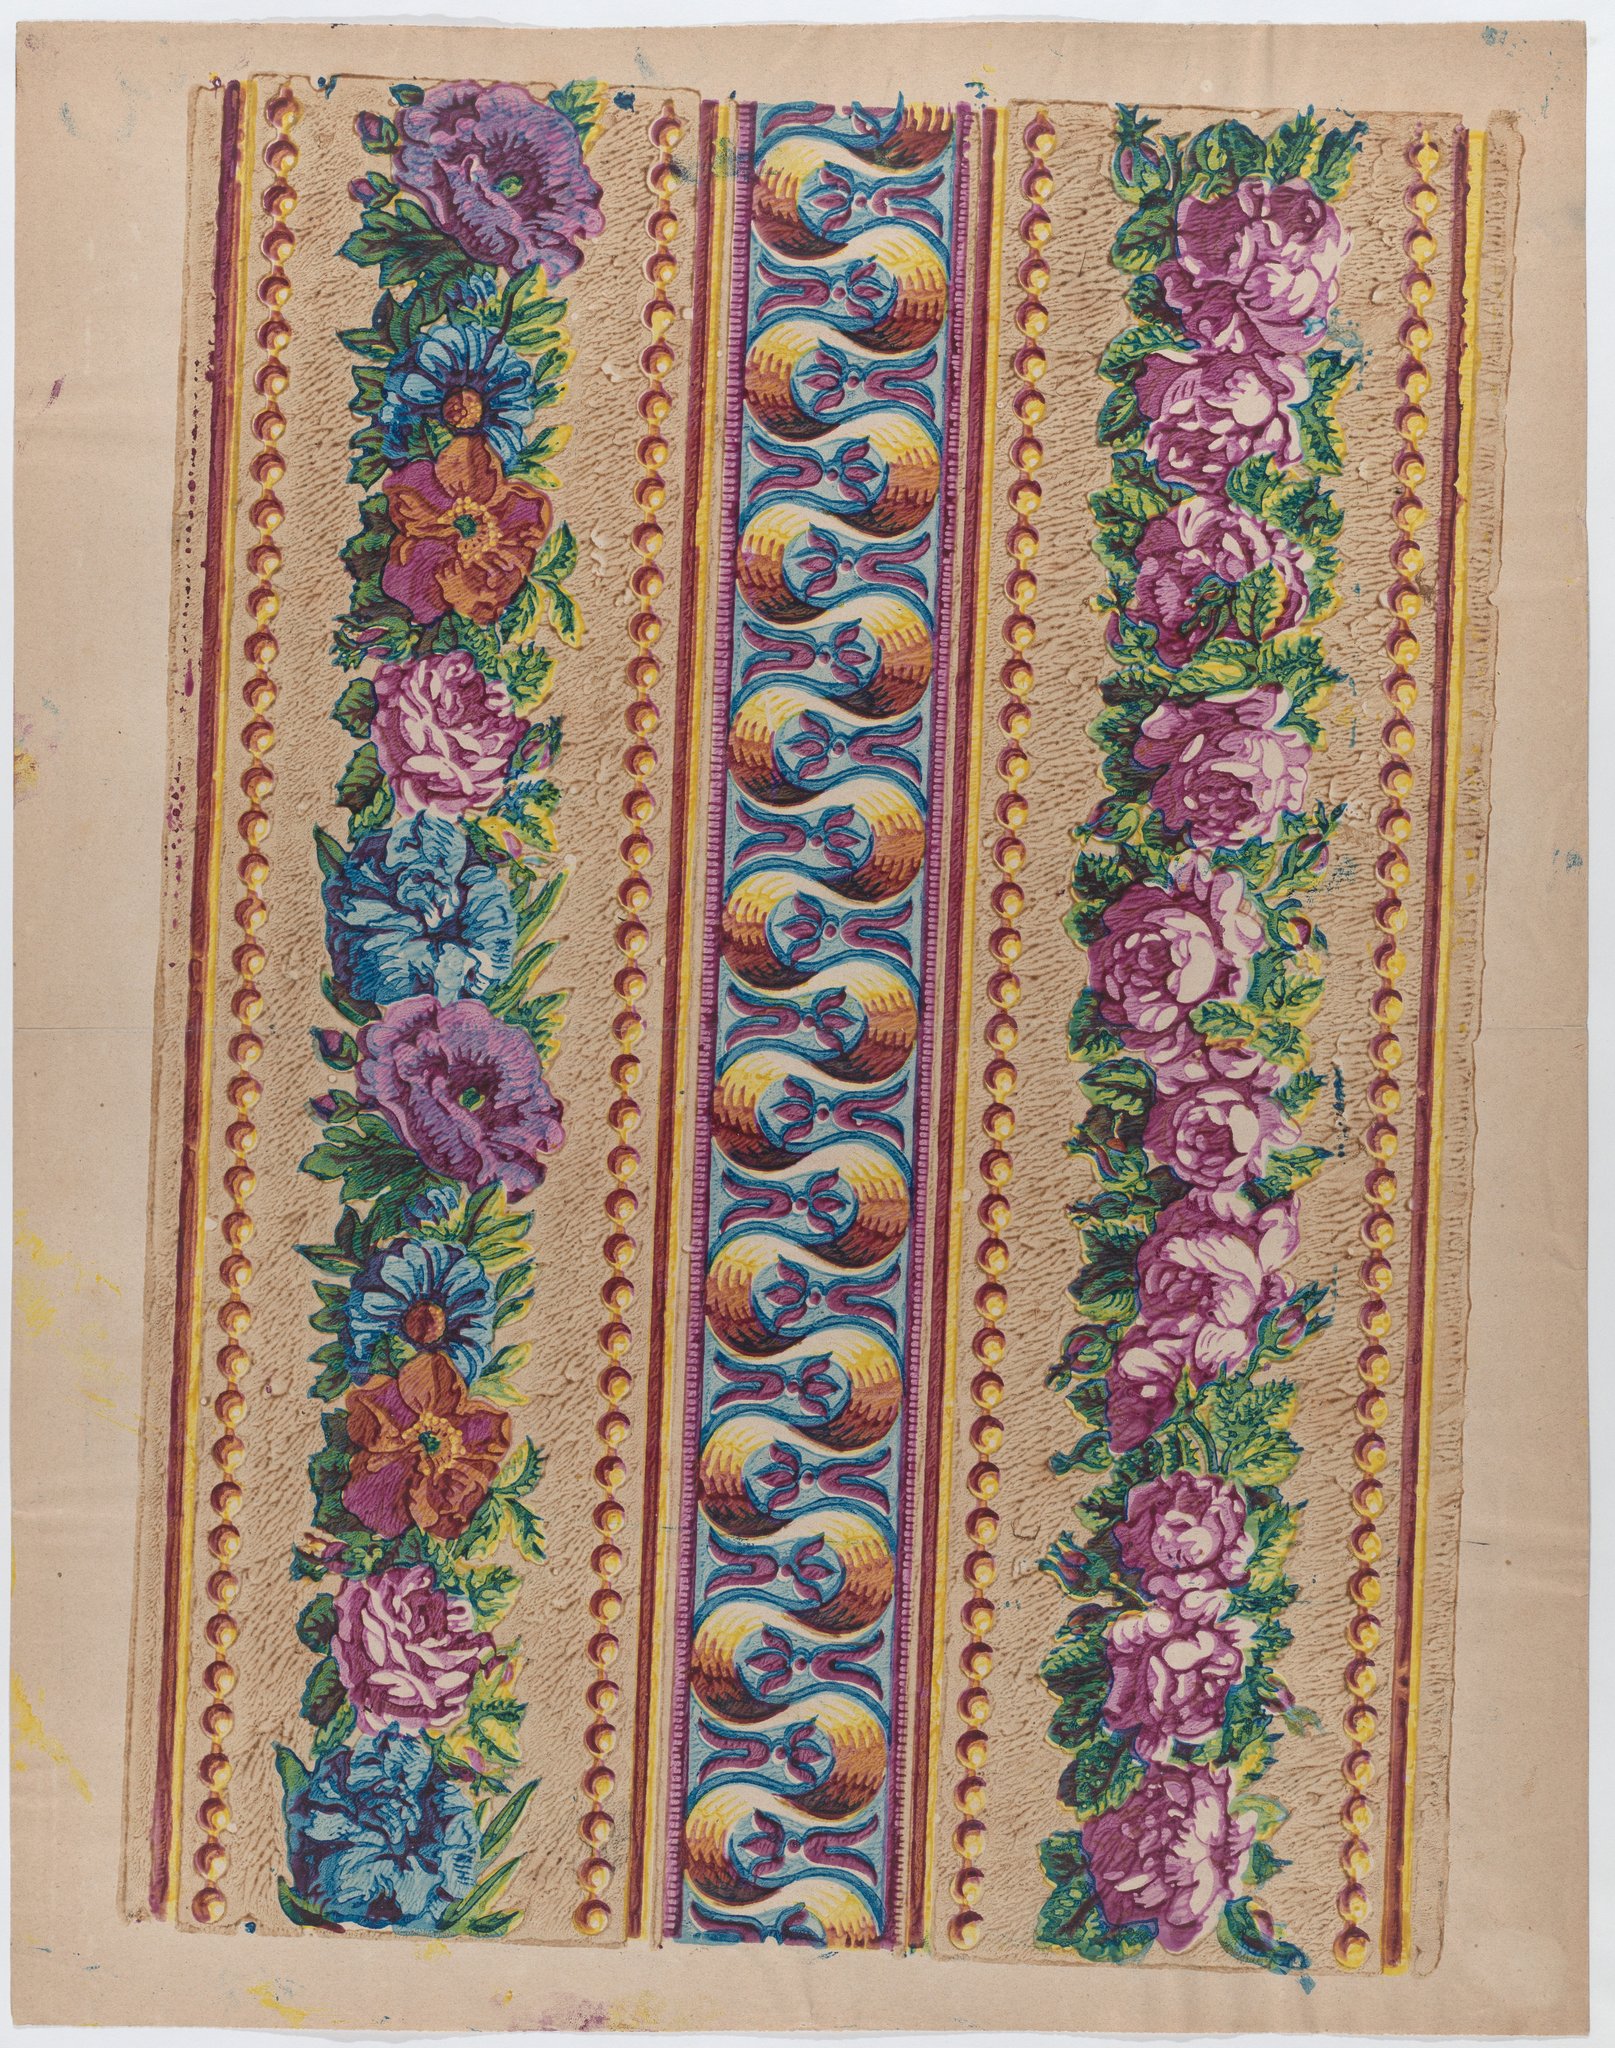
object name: print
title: Sheet with a border with pink and multicolor floral garlands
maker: Anonymous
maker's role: artist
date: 1767-1866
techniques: relief print